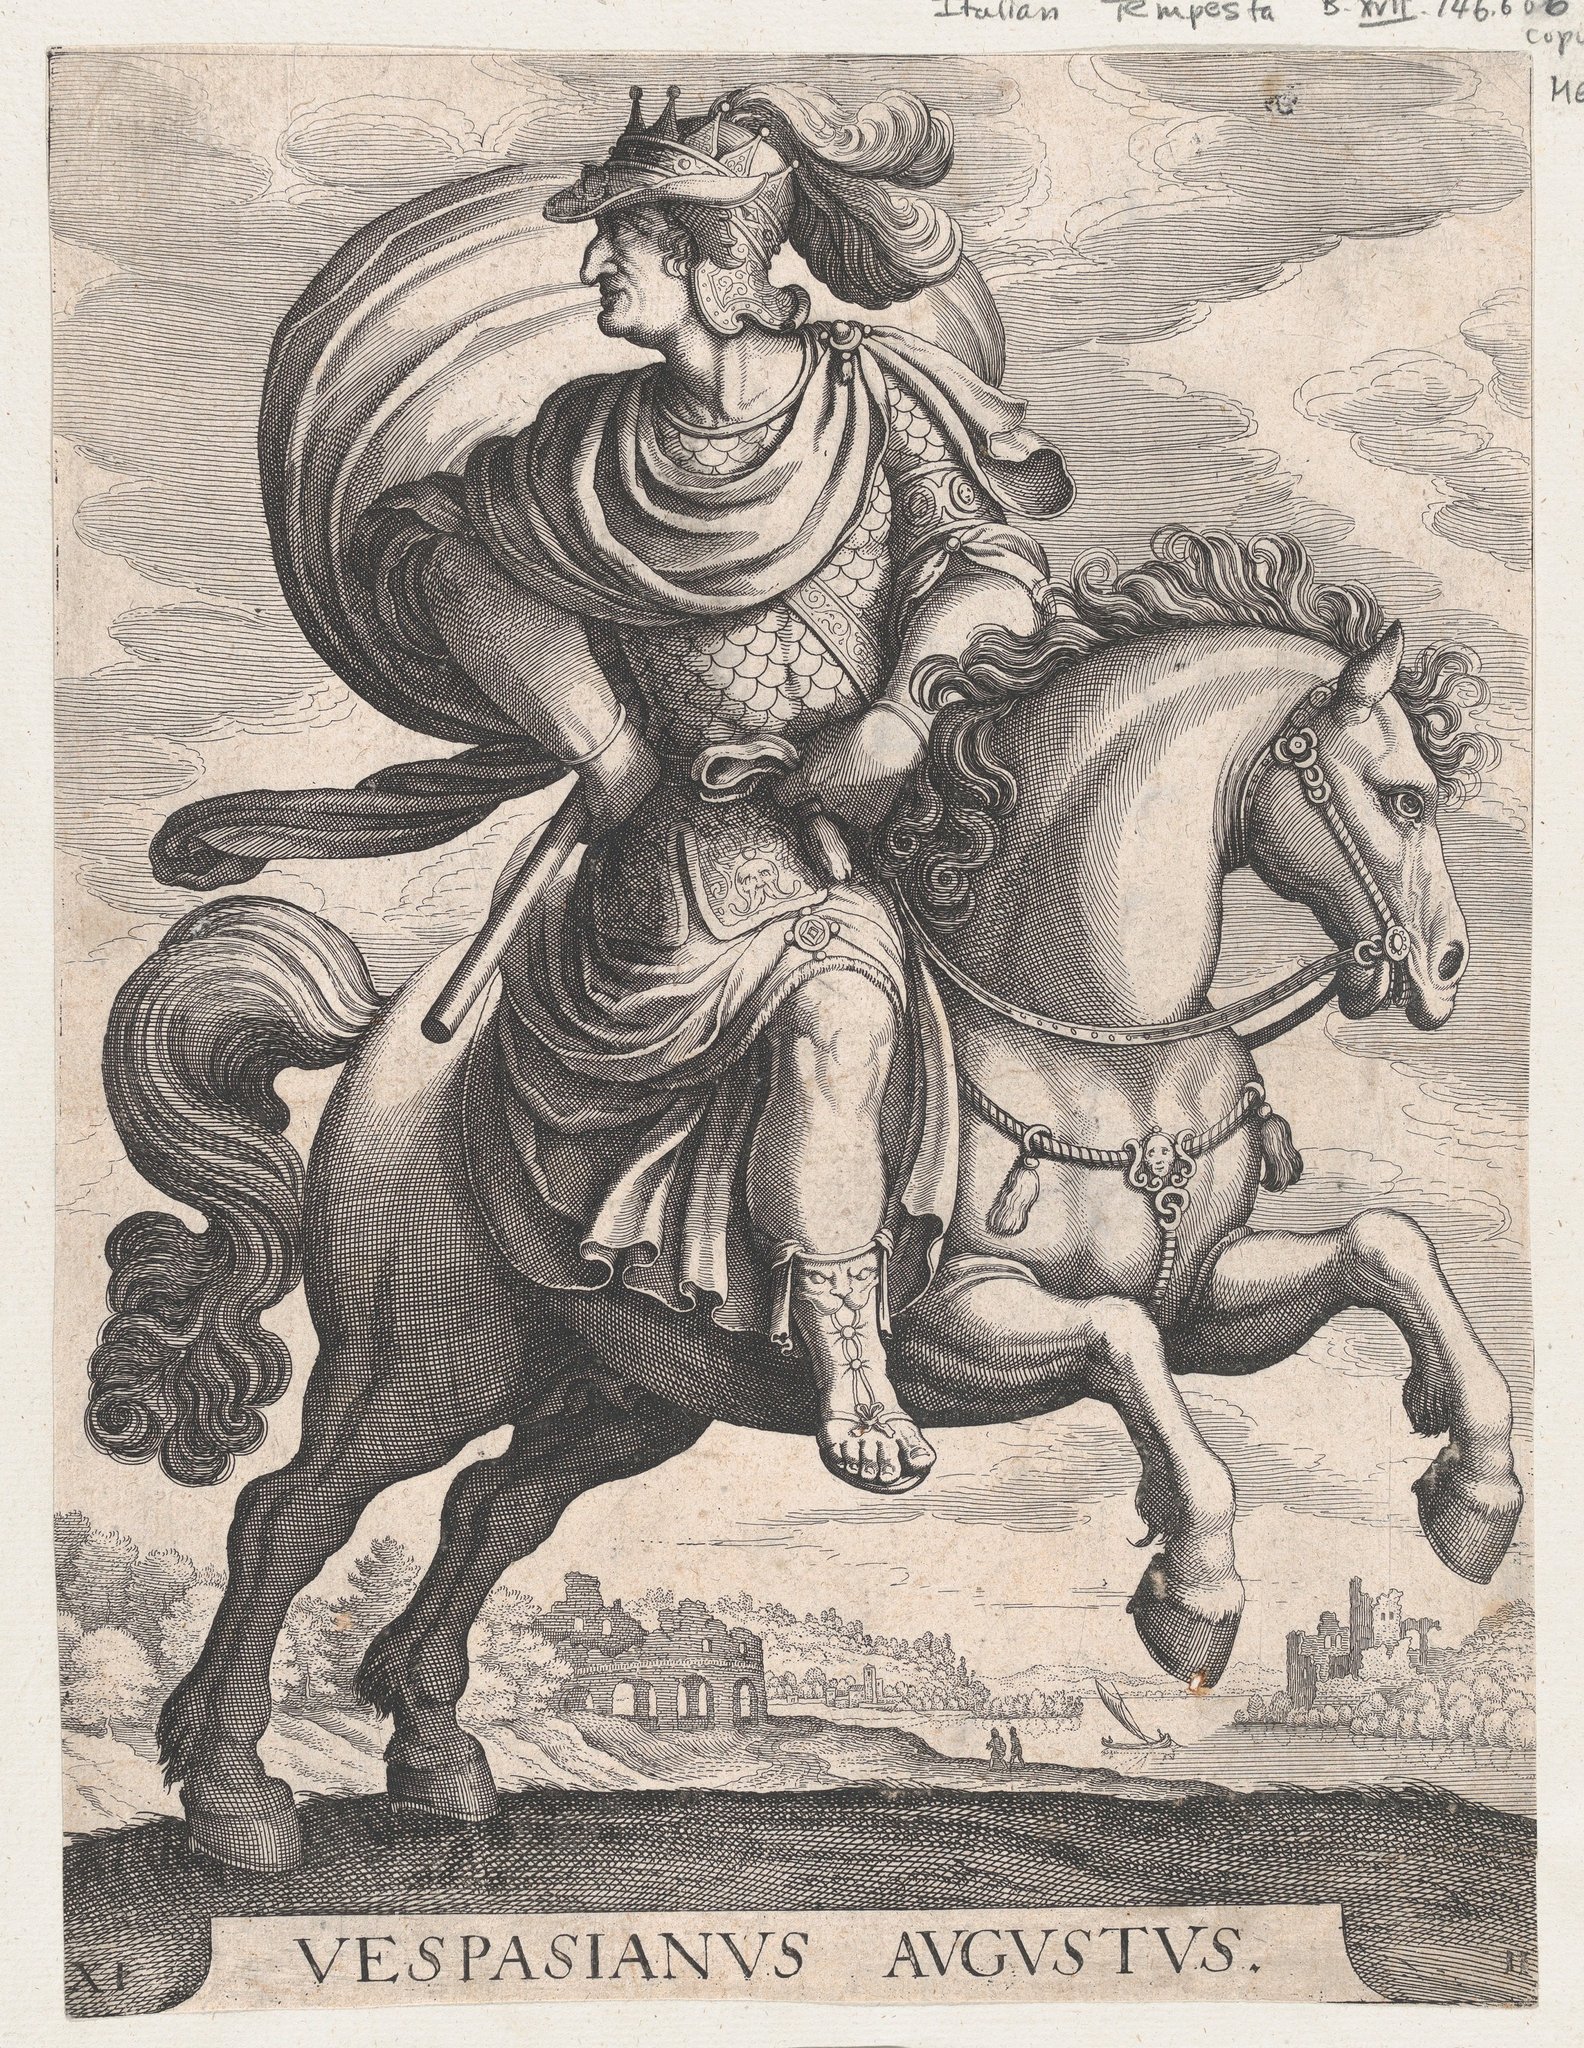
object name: print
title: Emperor Vespasian on Horseback, from the series The First Twelve Roman Caesars, plate 11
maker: matthäus merian the elder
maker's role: artist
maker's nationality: swiss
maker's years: 1593-1650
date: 1610-1650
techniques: etching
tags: men,horses